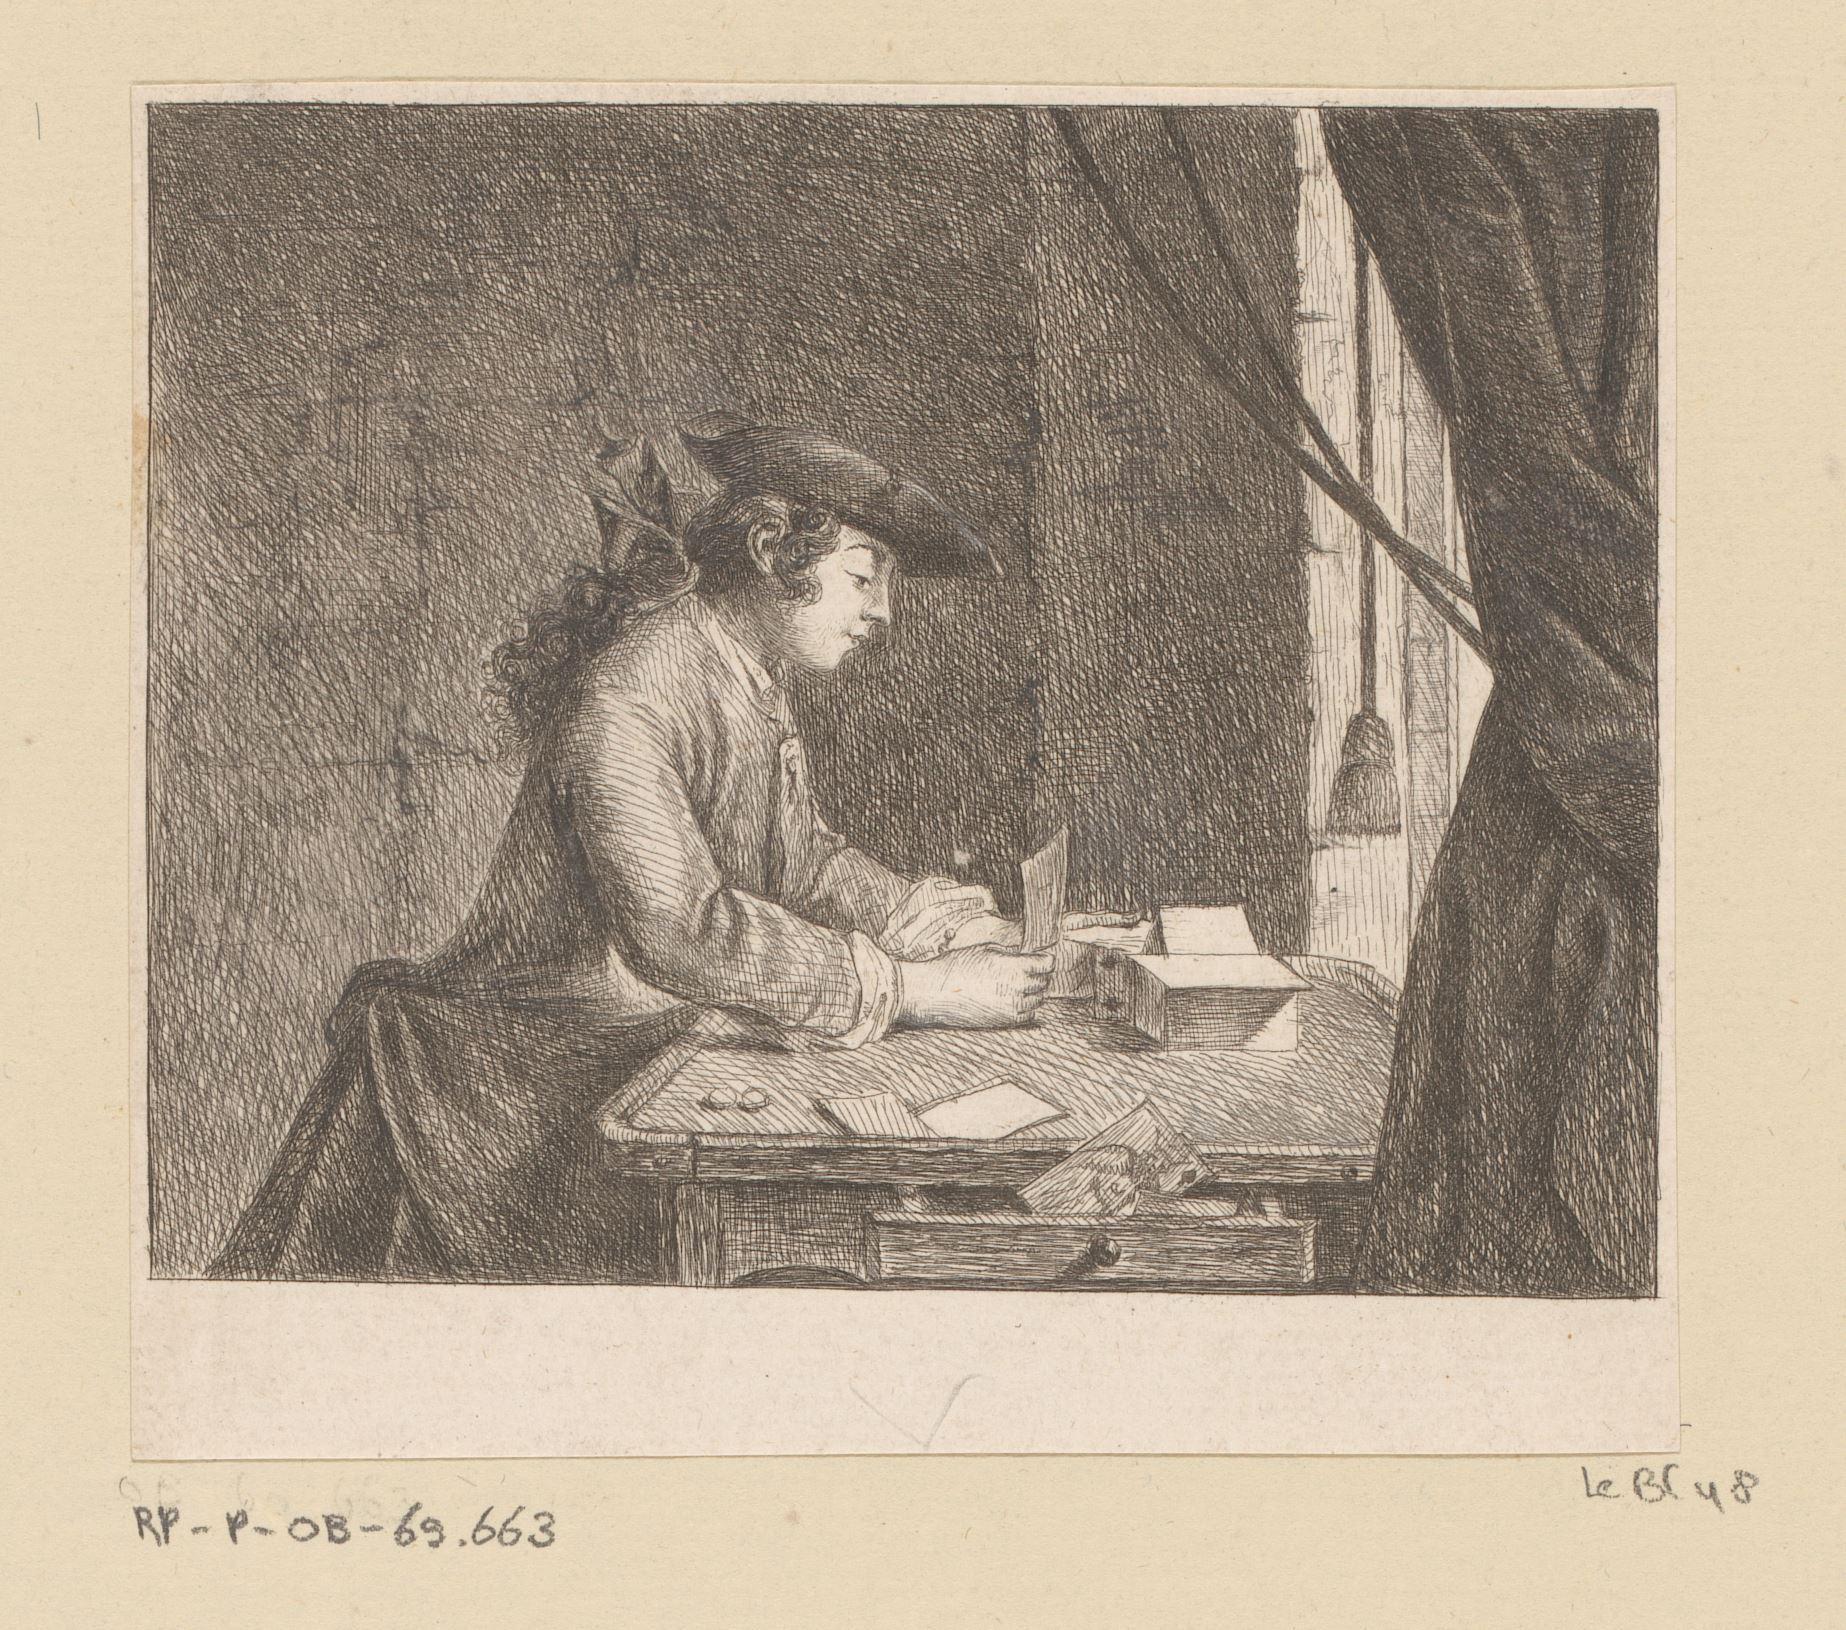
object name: print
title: Jongeman aan een tafel bouwt een kaartenhuis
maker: antoine de marcenay de ghuy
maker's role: print maker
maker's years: 1724-1811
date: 1734-1811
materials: paper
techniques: etching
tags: playing-cards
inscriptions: collector's mark: Lugt 2228